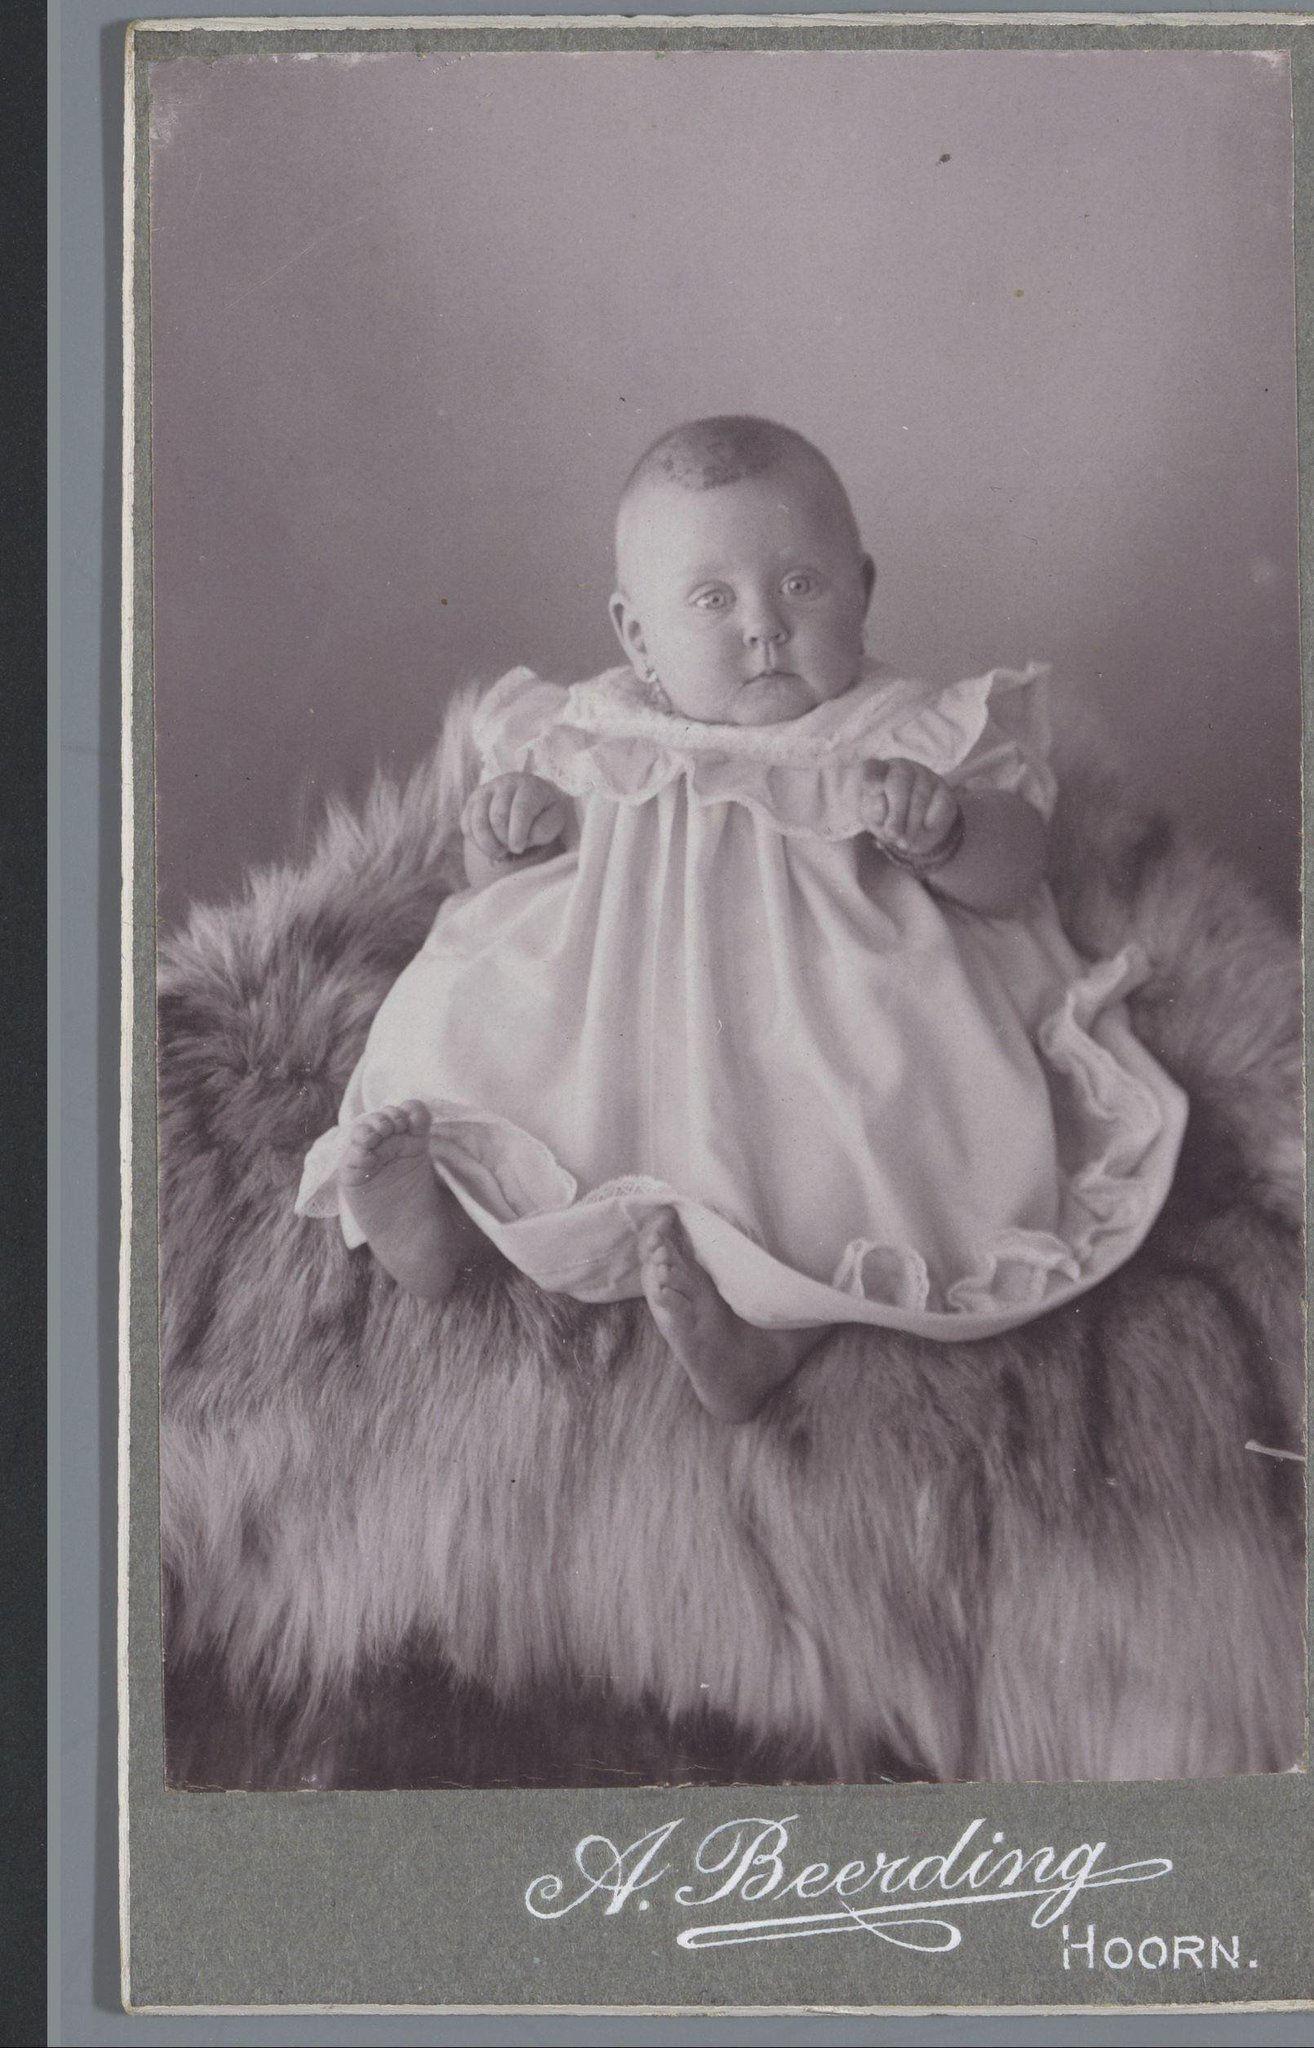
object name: carte de visite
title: Portret van Eegje Haan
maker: alida beerding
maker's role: fotograaf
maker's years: 1875-1949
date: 1912-1928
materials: cardboard, photographic support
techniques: collodion silver print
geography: hoorn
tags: historical persons, infant, baby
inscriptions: inscription: ‘Eegje Haan’